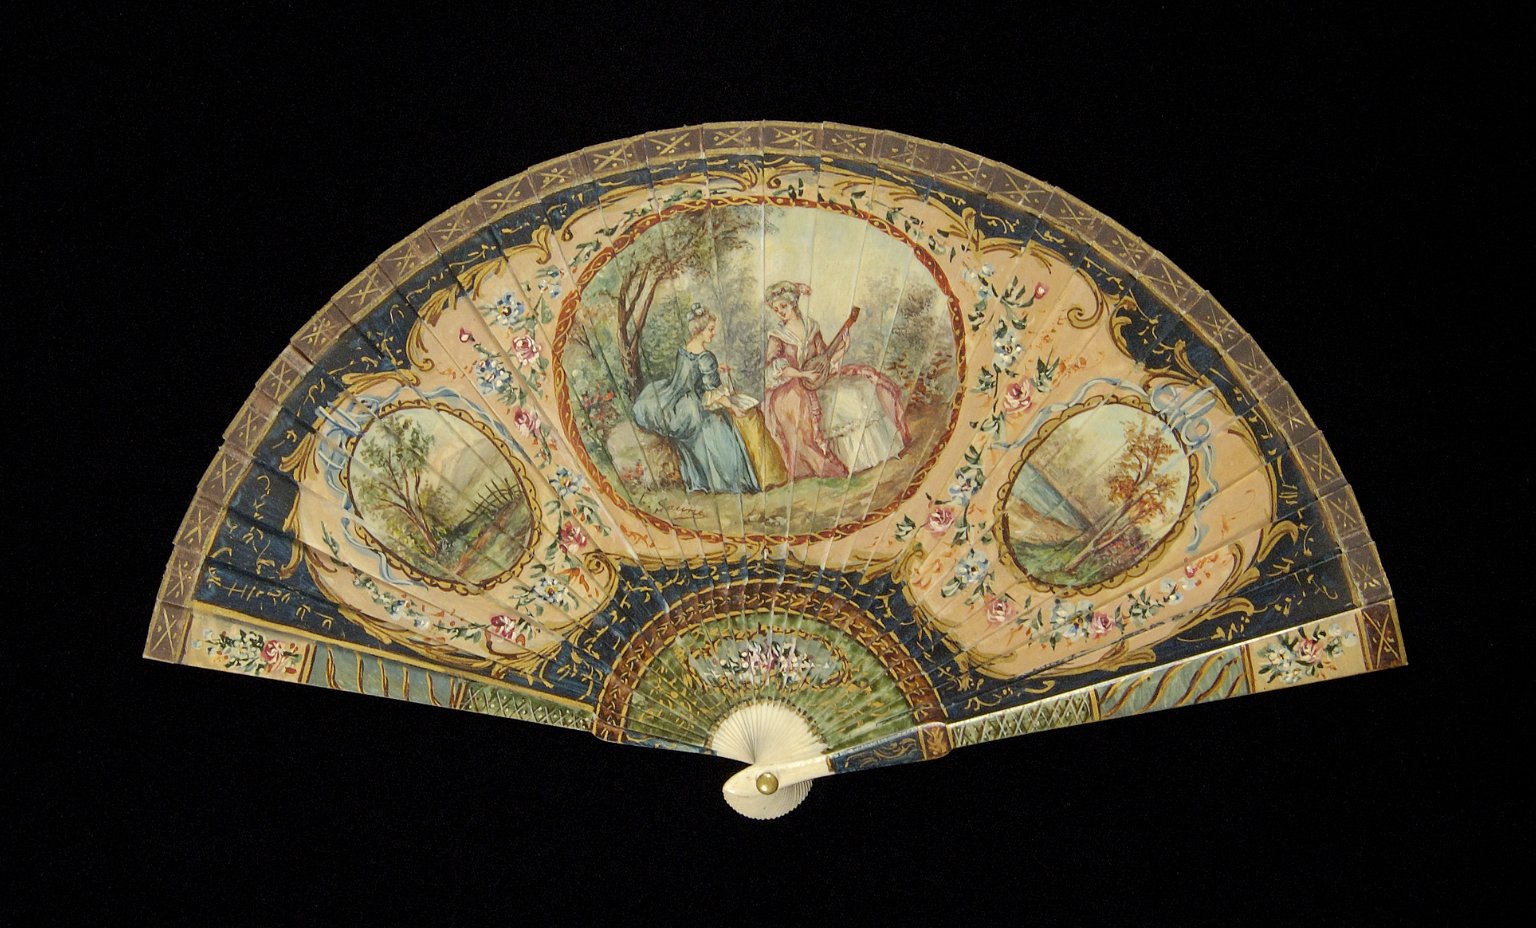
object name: brisé fan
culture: european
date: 1801-1825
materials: ivory, metal, paper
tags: musical instruments,women,flowers